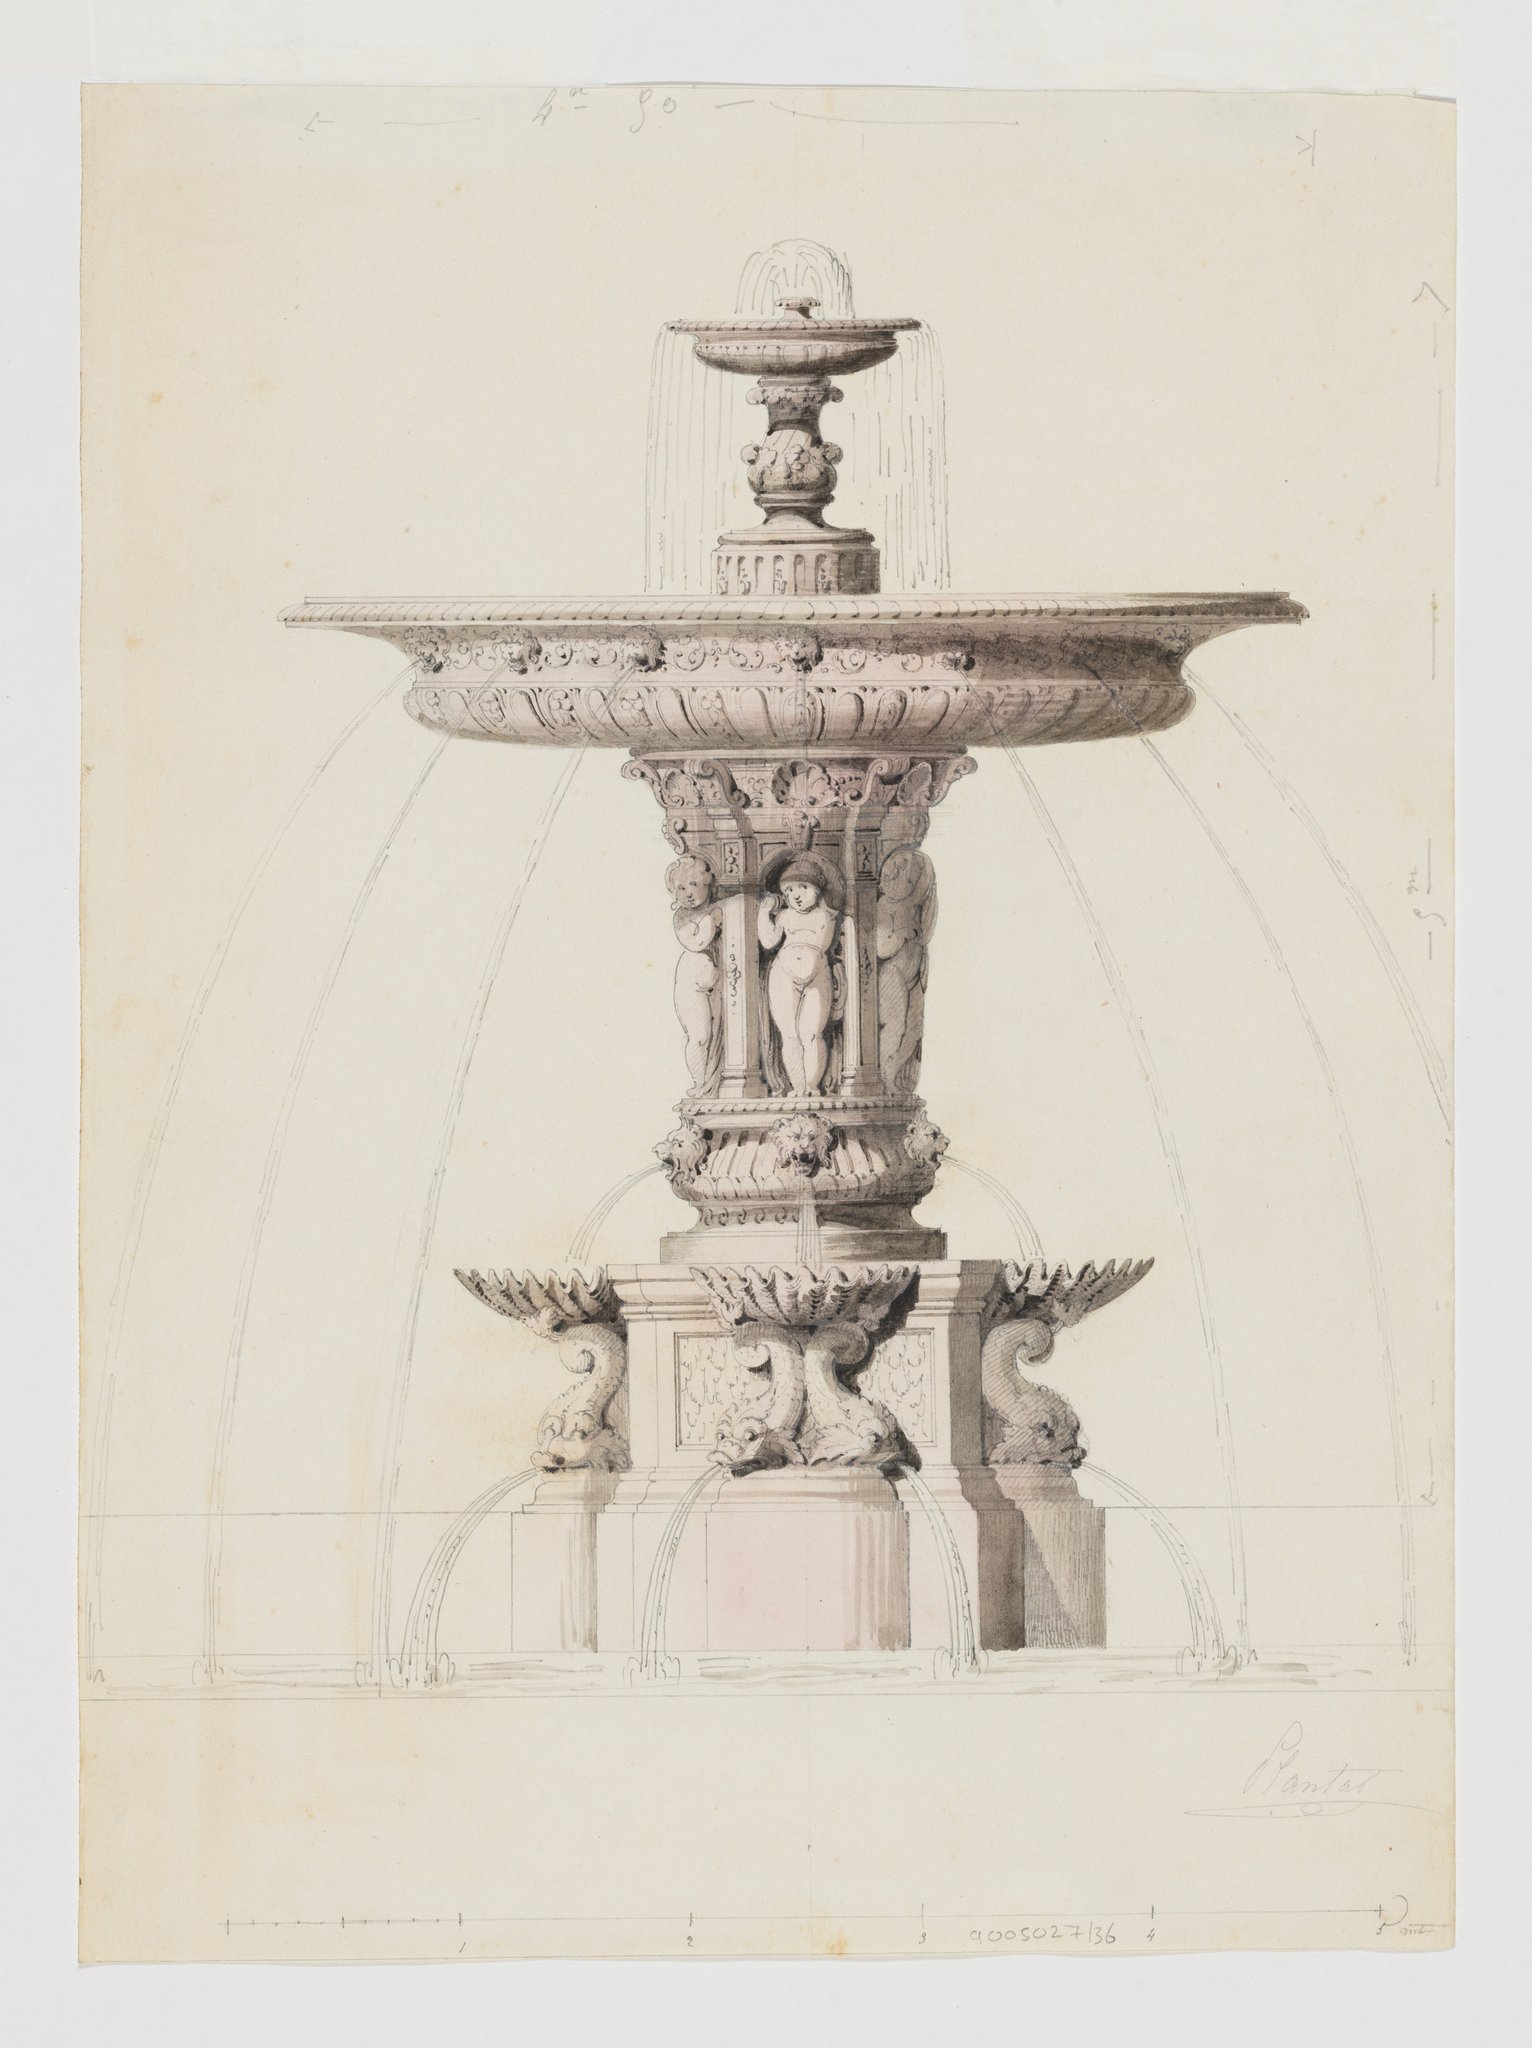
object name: drawing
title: Design for a Fountain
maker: jean-baptiste louis plantar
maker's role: artist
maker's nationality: french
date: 1834-1866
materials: graphite, ink, watercolor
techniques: pen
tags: fountains